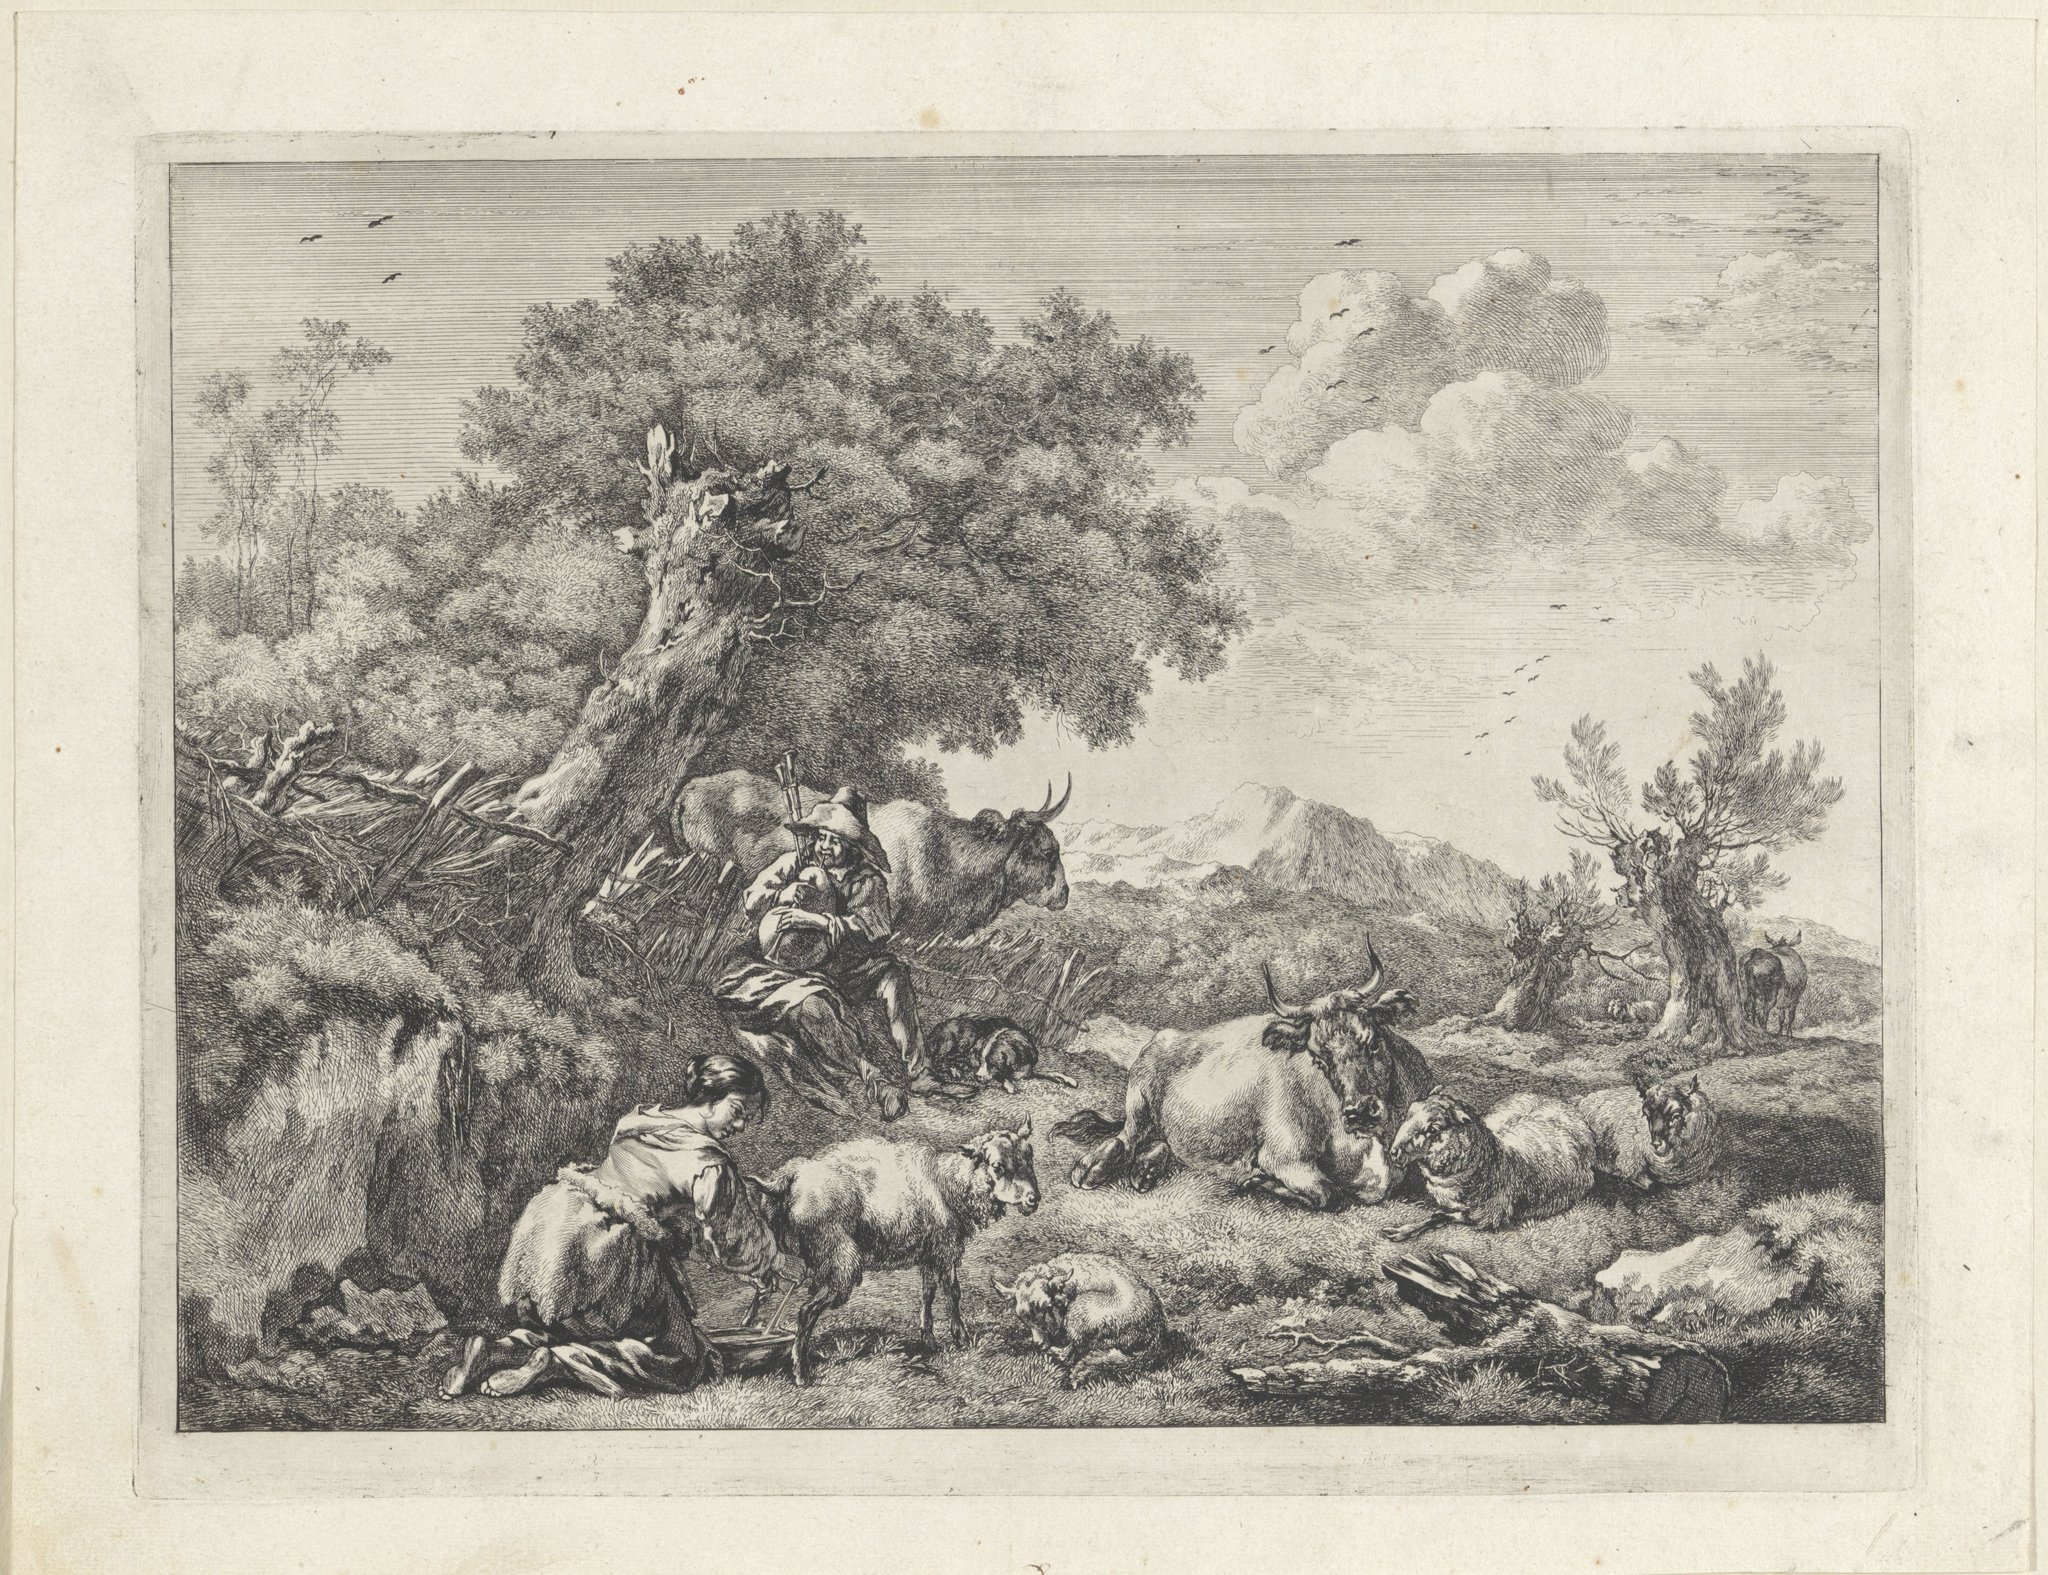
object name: print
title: Herder speelt doedelzak terwijl een meisje een schaap melkt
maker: jan de visscher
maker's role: print maker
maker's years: 1633-1712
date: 1643-1692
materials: paper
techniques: engraving, etching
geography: northern netherlands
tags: herding, herdsman, herdswoman, shepherd, shepherdess, cowherd, etc., one person playing wind instrument, bagpipe, musette, milking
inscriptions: collector's mark: Lugt 240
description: Gezicht op een berglandschap met op de voorgrond een doedelzak spelende herder en een meisje die een schaap melkt. Bij de herder en het meisje bevinden zich koeien en schapen.